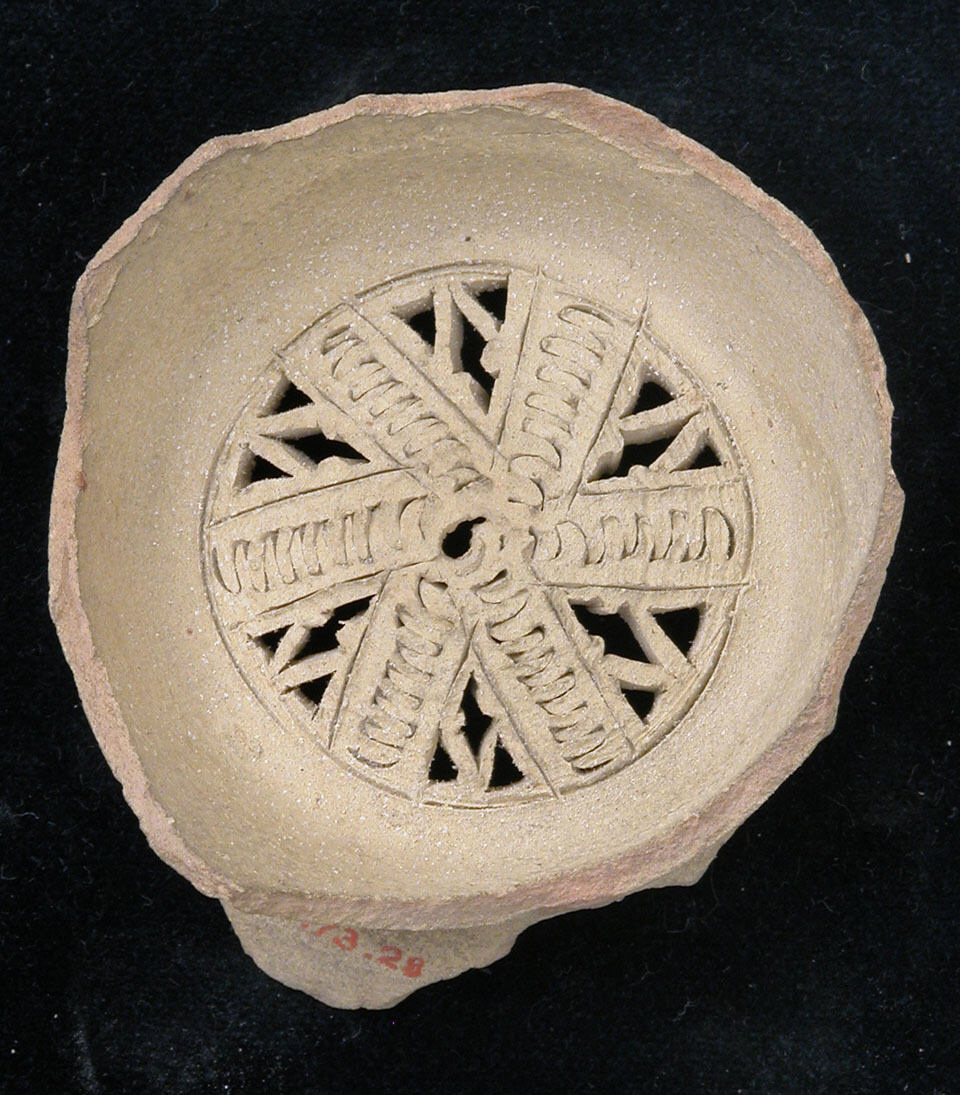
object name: water filter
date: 901-1200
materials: earthenware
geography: egypt